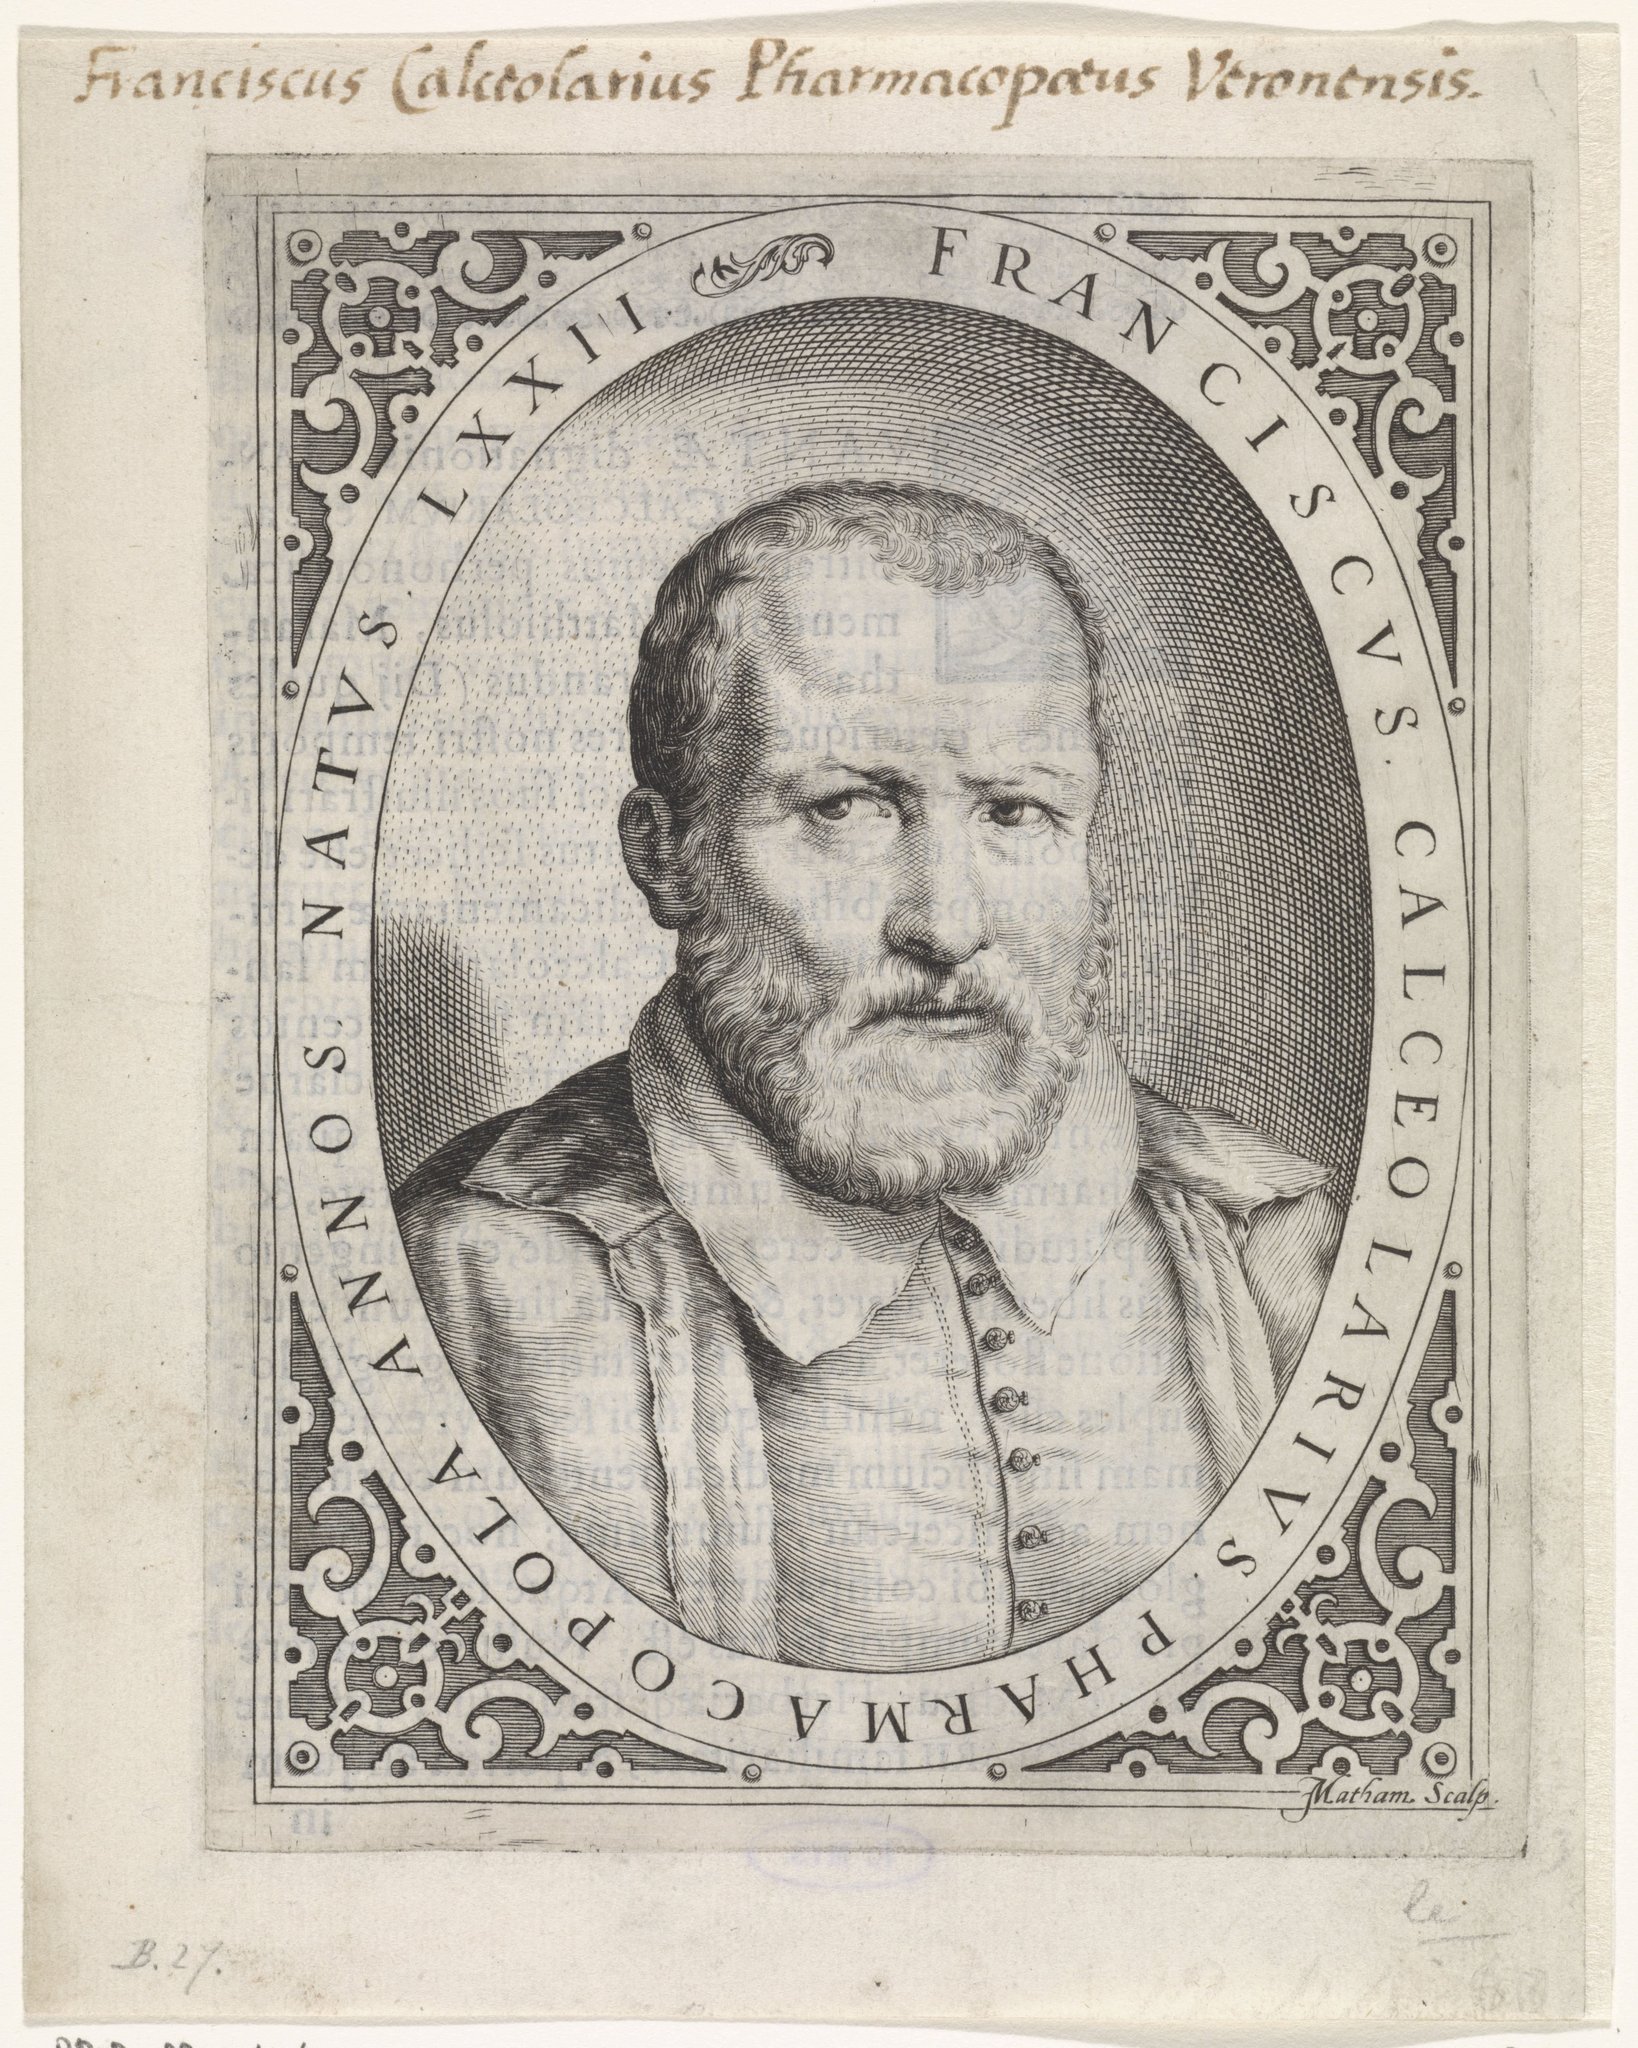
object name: book illustration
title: Portret van Francisco Calzolari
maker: jacob matham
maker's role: draughtsman, print maker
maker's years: 1571-1631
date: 1591-1596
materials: ink, paper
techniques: engraving, letterpress printing, pen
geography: haarlem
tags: moustache, historical persons, beard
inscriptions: edge inscription: ‘FRANCISCUS CALCEOLARIUS PHARMACOPOLA...LXII’, inscription: ‘Franciscus Calceolarius Pharmacopatus Veronensis’, collector's mark: Lugt 2228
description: Portret van de pharmaceut Francisco Calzolari, op 72- jarige leeftijd.